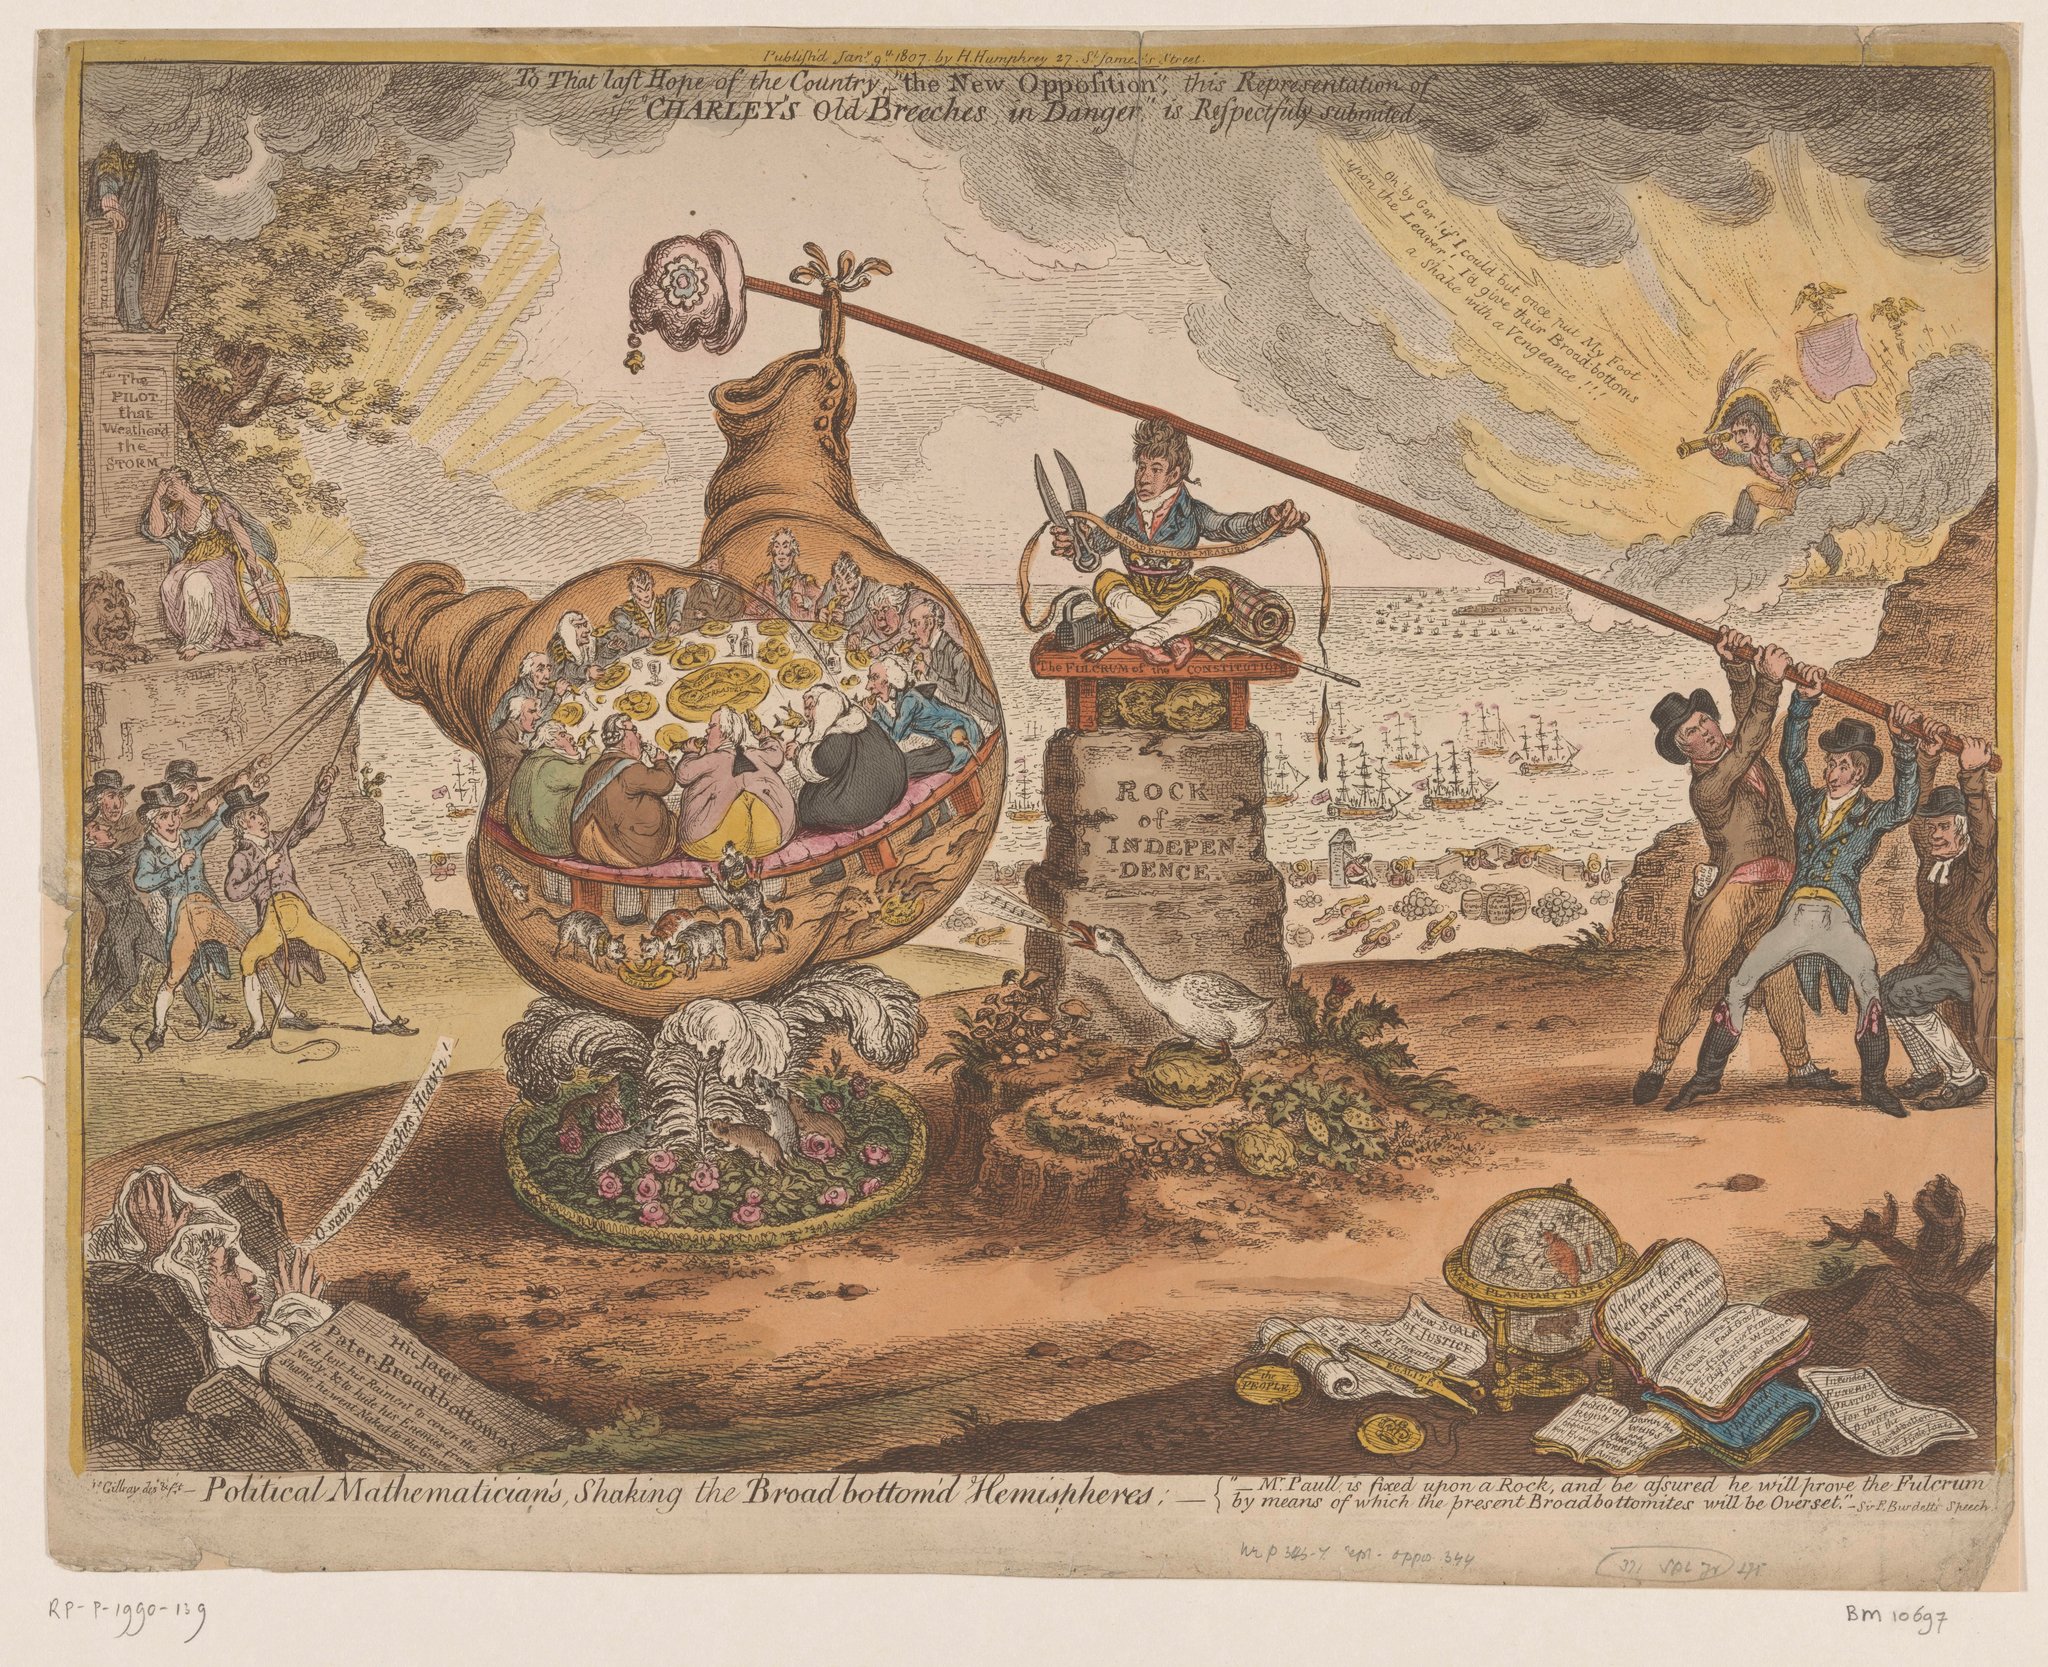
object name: cartoon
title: Britse politieke spotprent, 1807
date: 1807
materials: paper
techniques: etching, hand coloring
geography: england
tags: napoleon i (emperor of the french), trousers, breeches, political caricatures and satires, england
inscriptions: collector's mark: Lugt 2760, collector's mark: Lugt 2228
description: Spotprent op de Britse binnenlandse politiek, 1807. Centraal een grote broek die ondersteboven wordt gehezen. Verder allerlei getouwtrek en schranspartijen. Vanuit brandend Europa kijkt Napoleon met een verrekijker naar de Engelse toestanden.